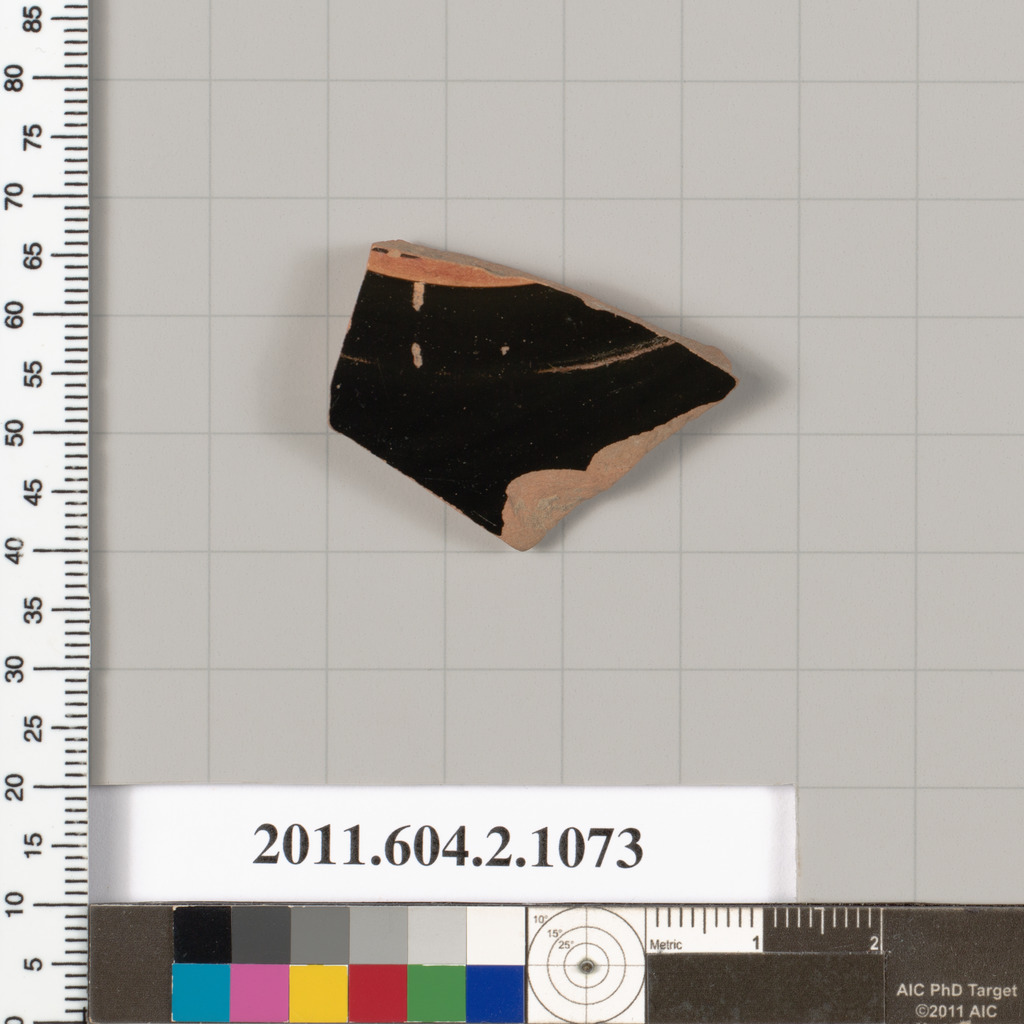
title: Terracotta fragment of an open shape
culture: greek, attic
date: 500-401 BCE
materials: terracotta